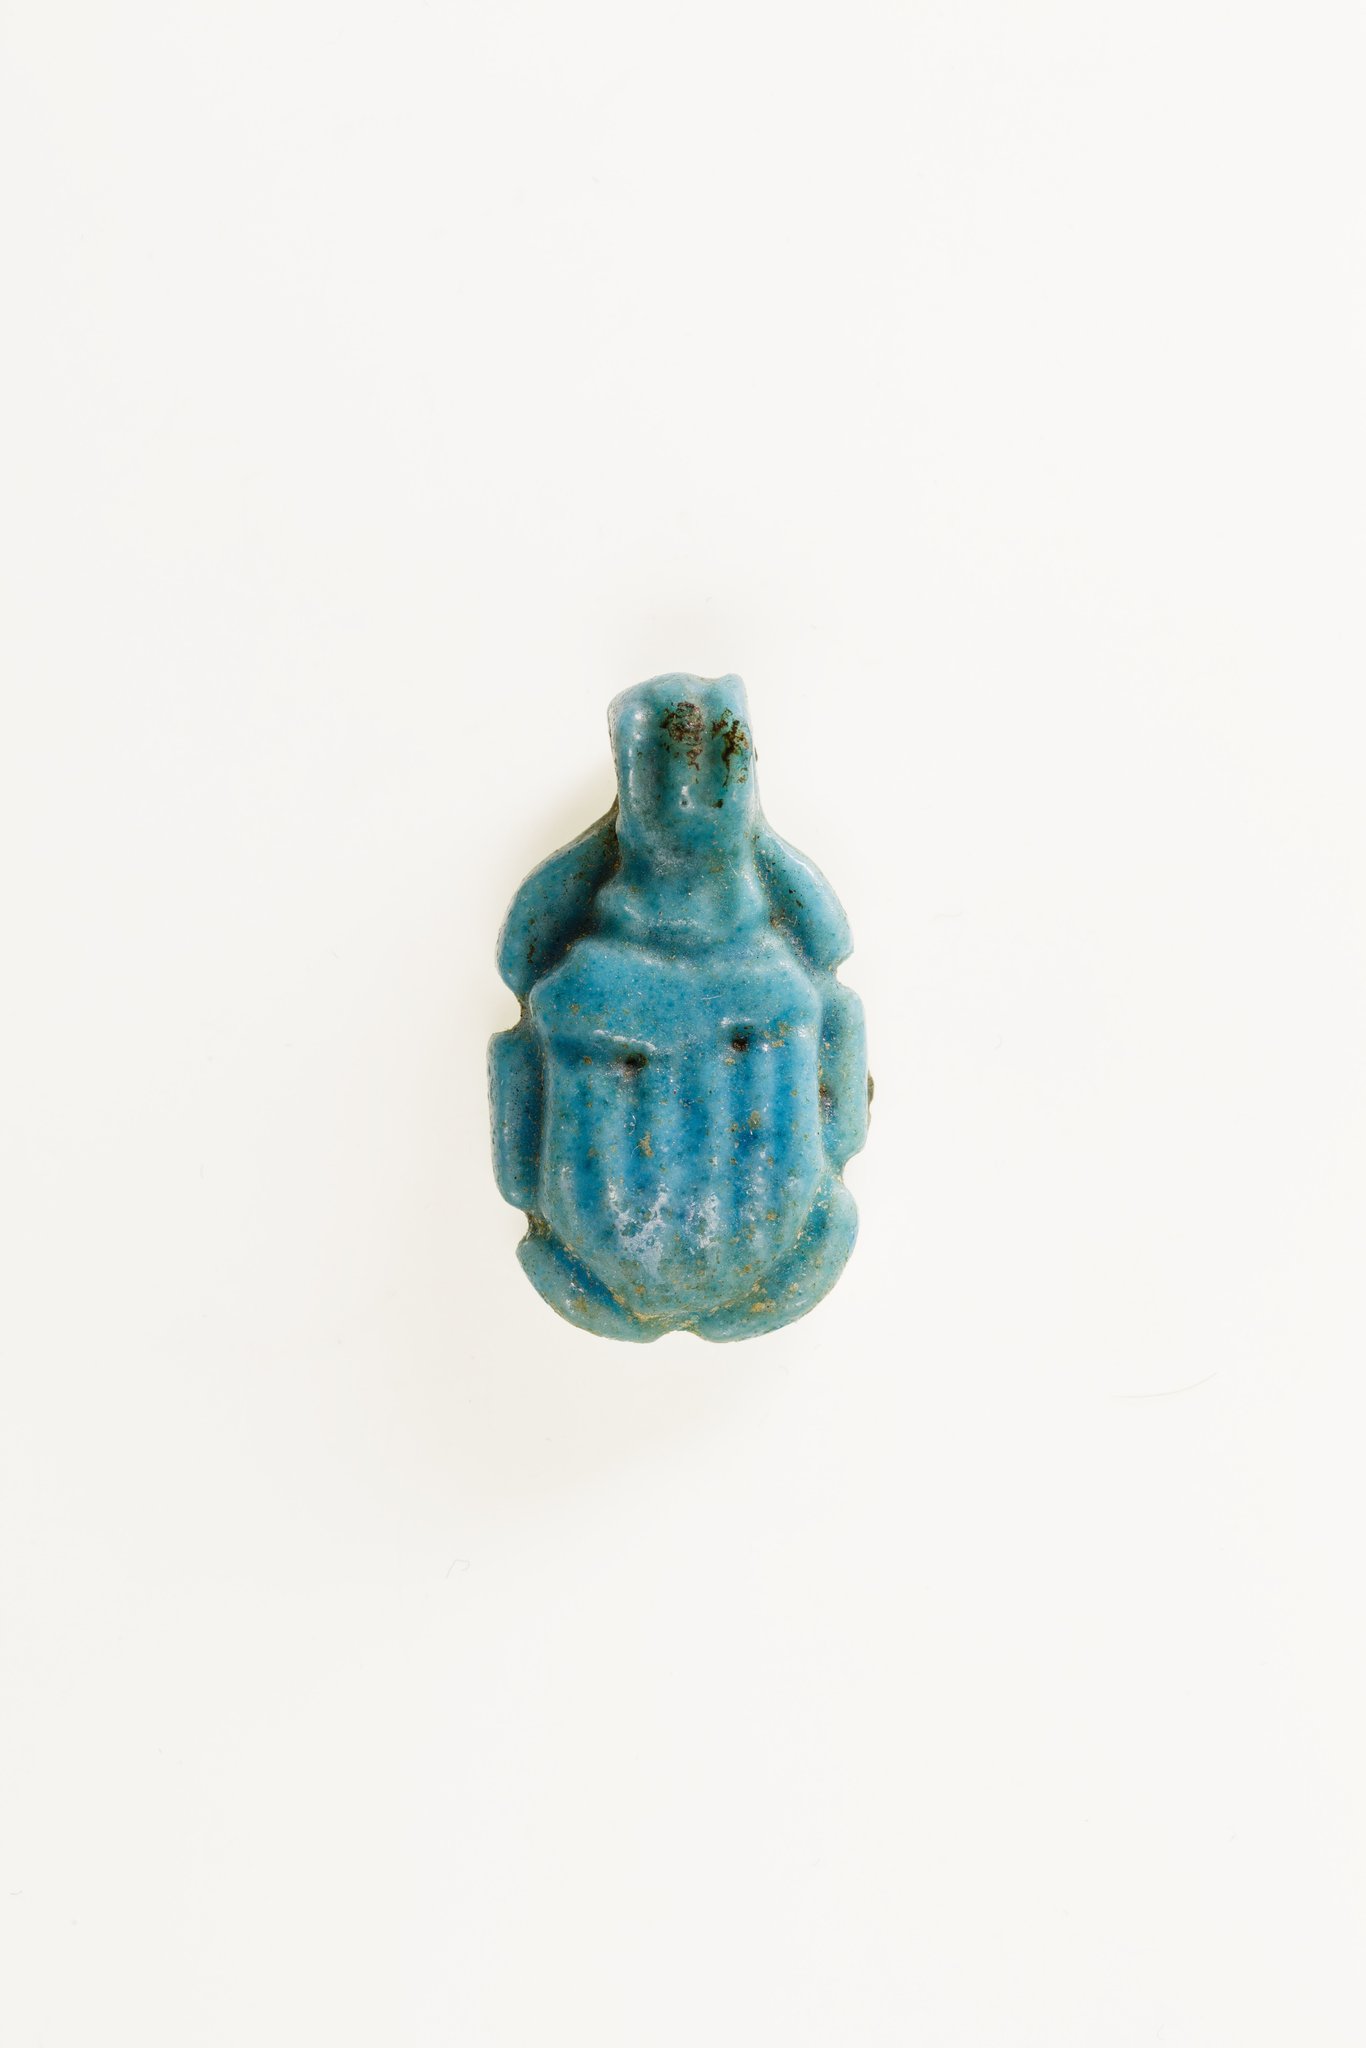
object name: scarab, mummy scarab, loop at top, amulet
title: Scarab amulet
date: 712-332 BCE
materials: faience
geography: egypt